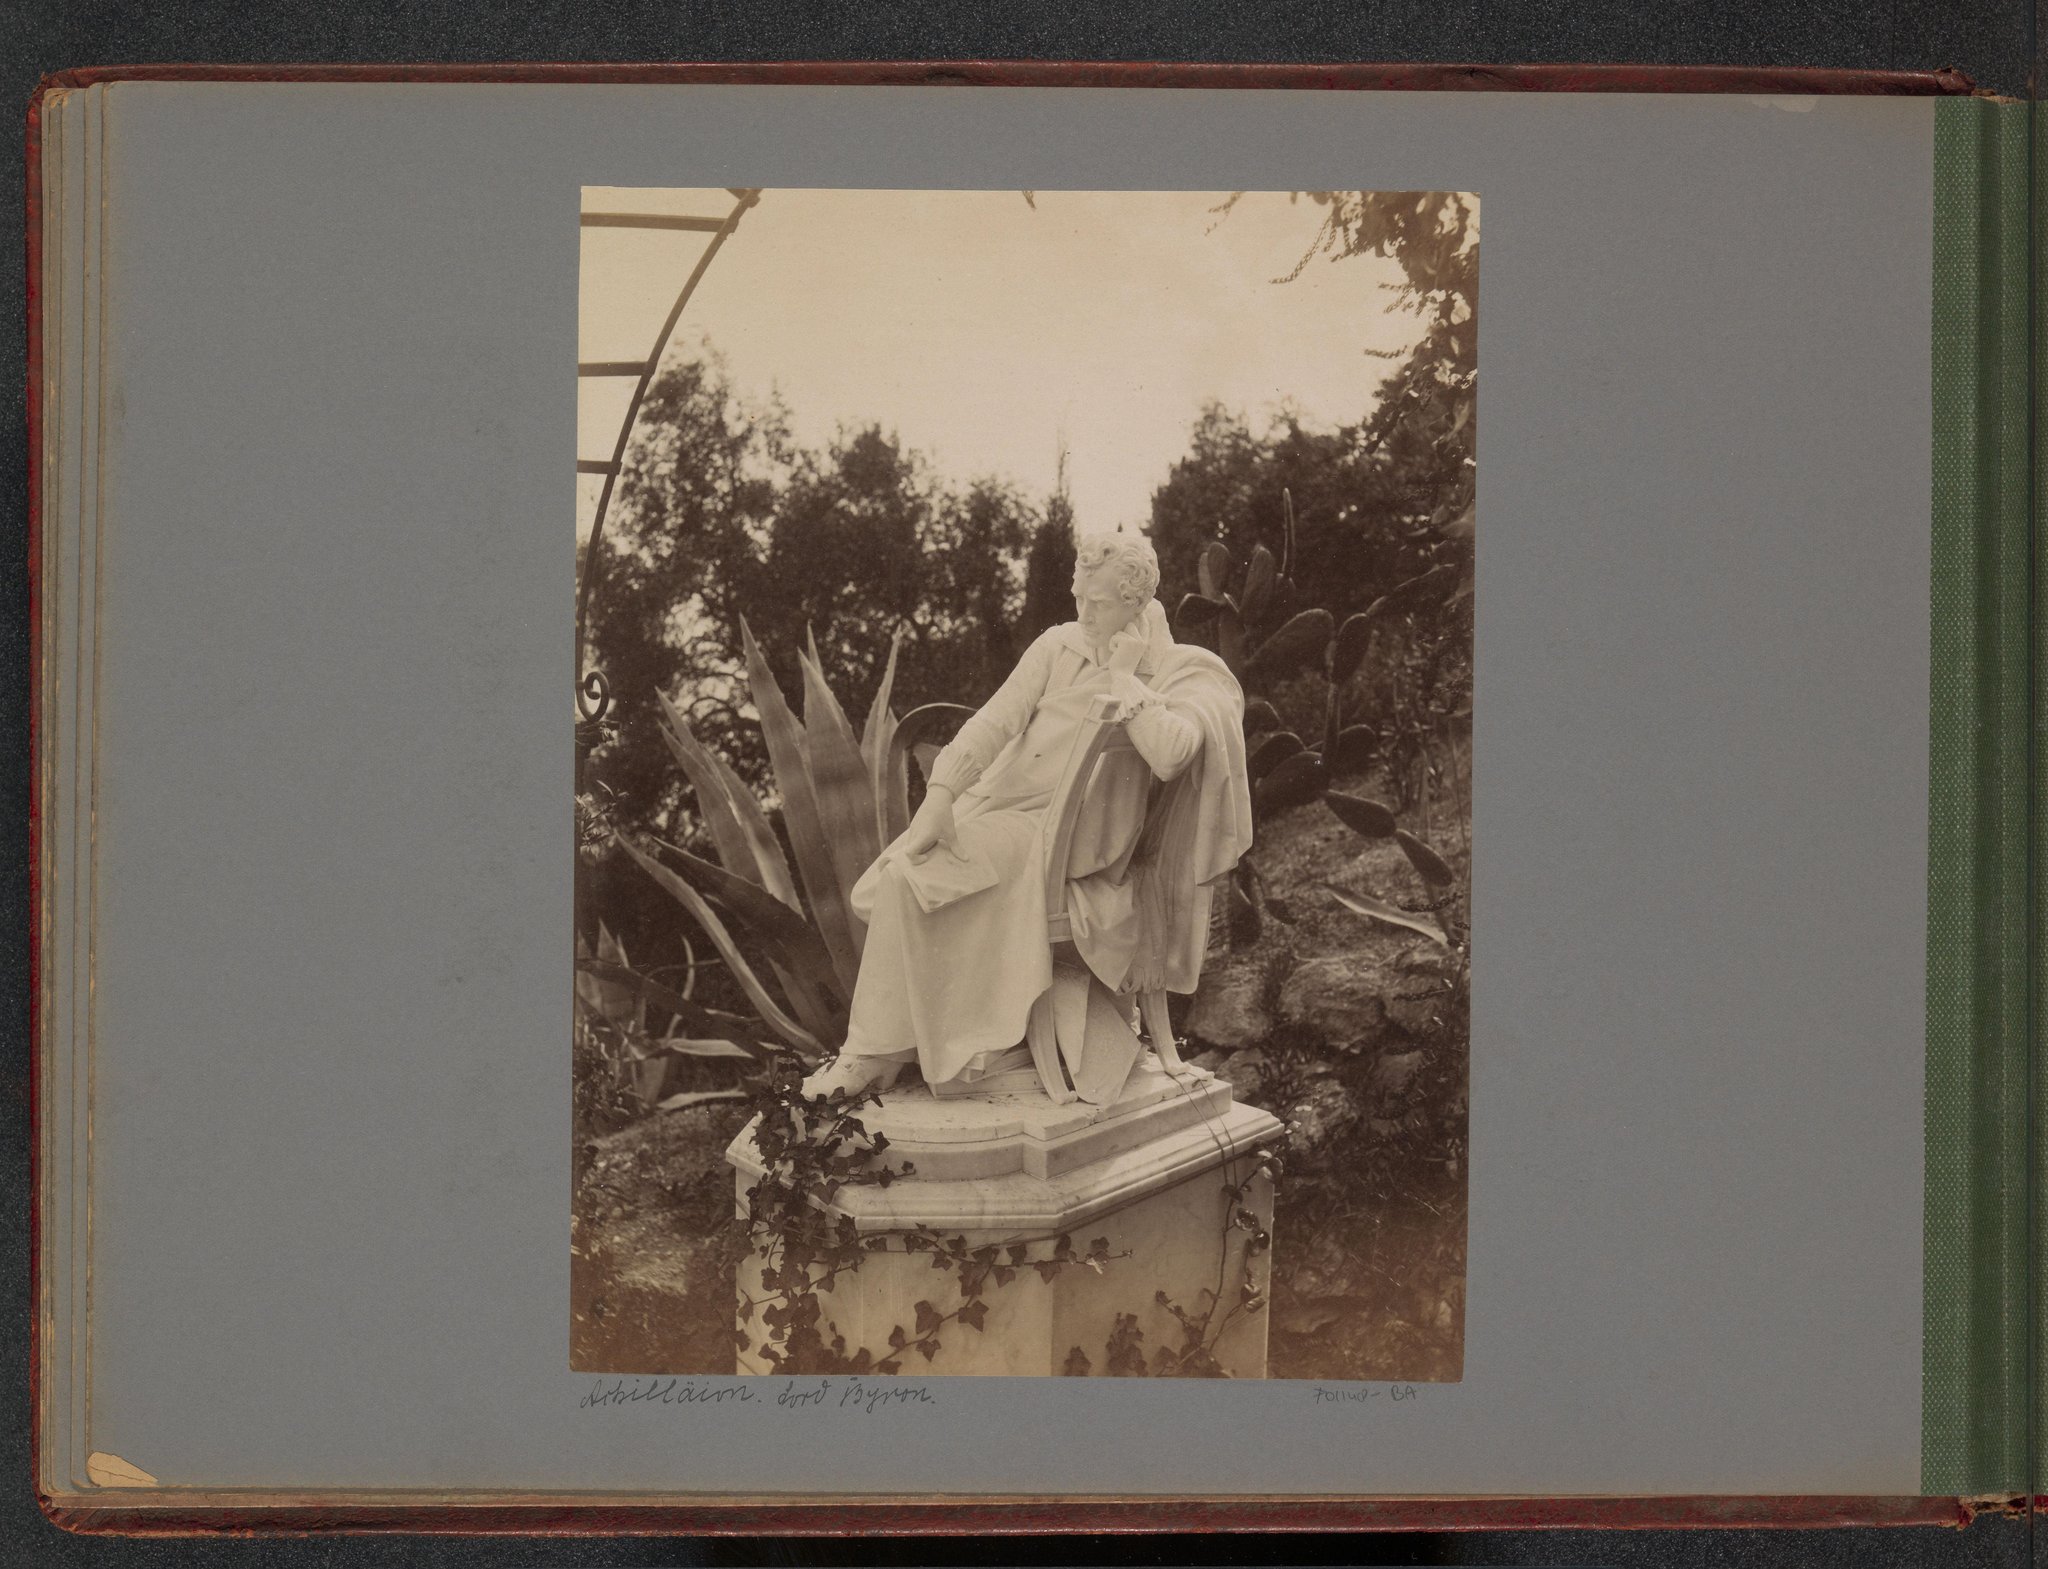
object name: album leaf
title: Beeld van Lord Byron bij het Achilleion op Corfu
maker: Anonymous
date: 1895-1905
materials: paper, photographic support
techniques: albumen print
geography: corfu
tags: london, lord byron, piece of sculpture, reproduction of a piece of sculpture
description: Onderdeel van Reisalbum met foto's van bezienswaardigheden in Griekenland en Egypte.